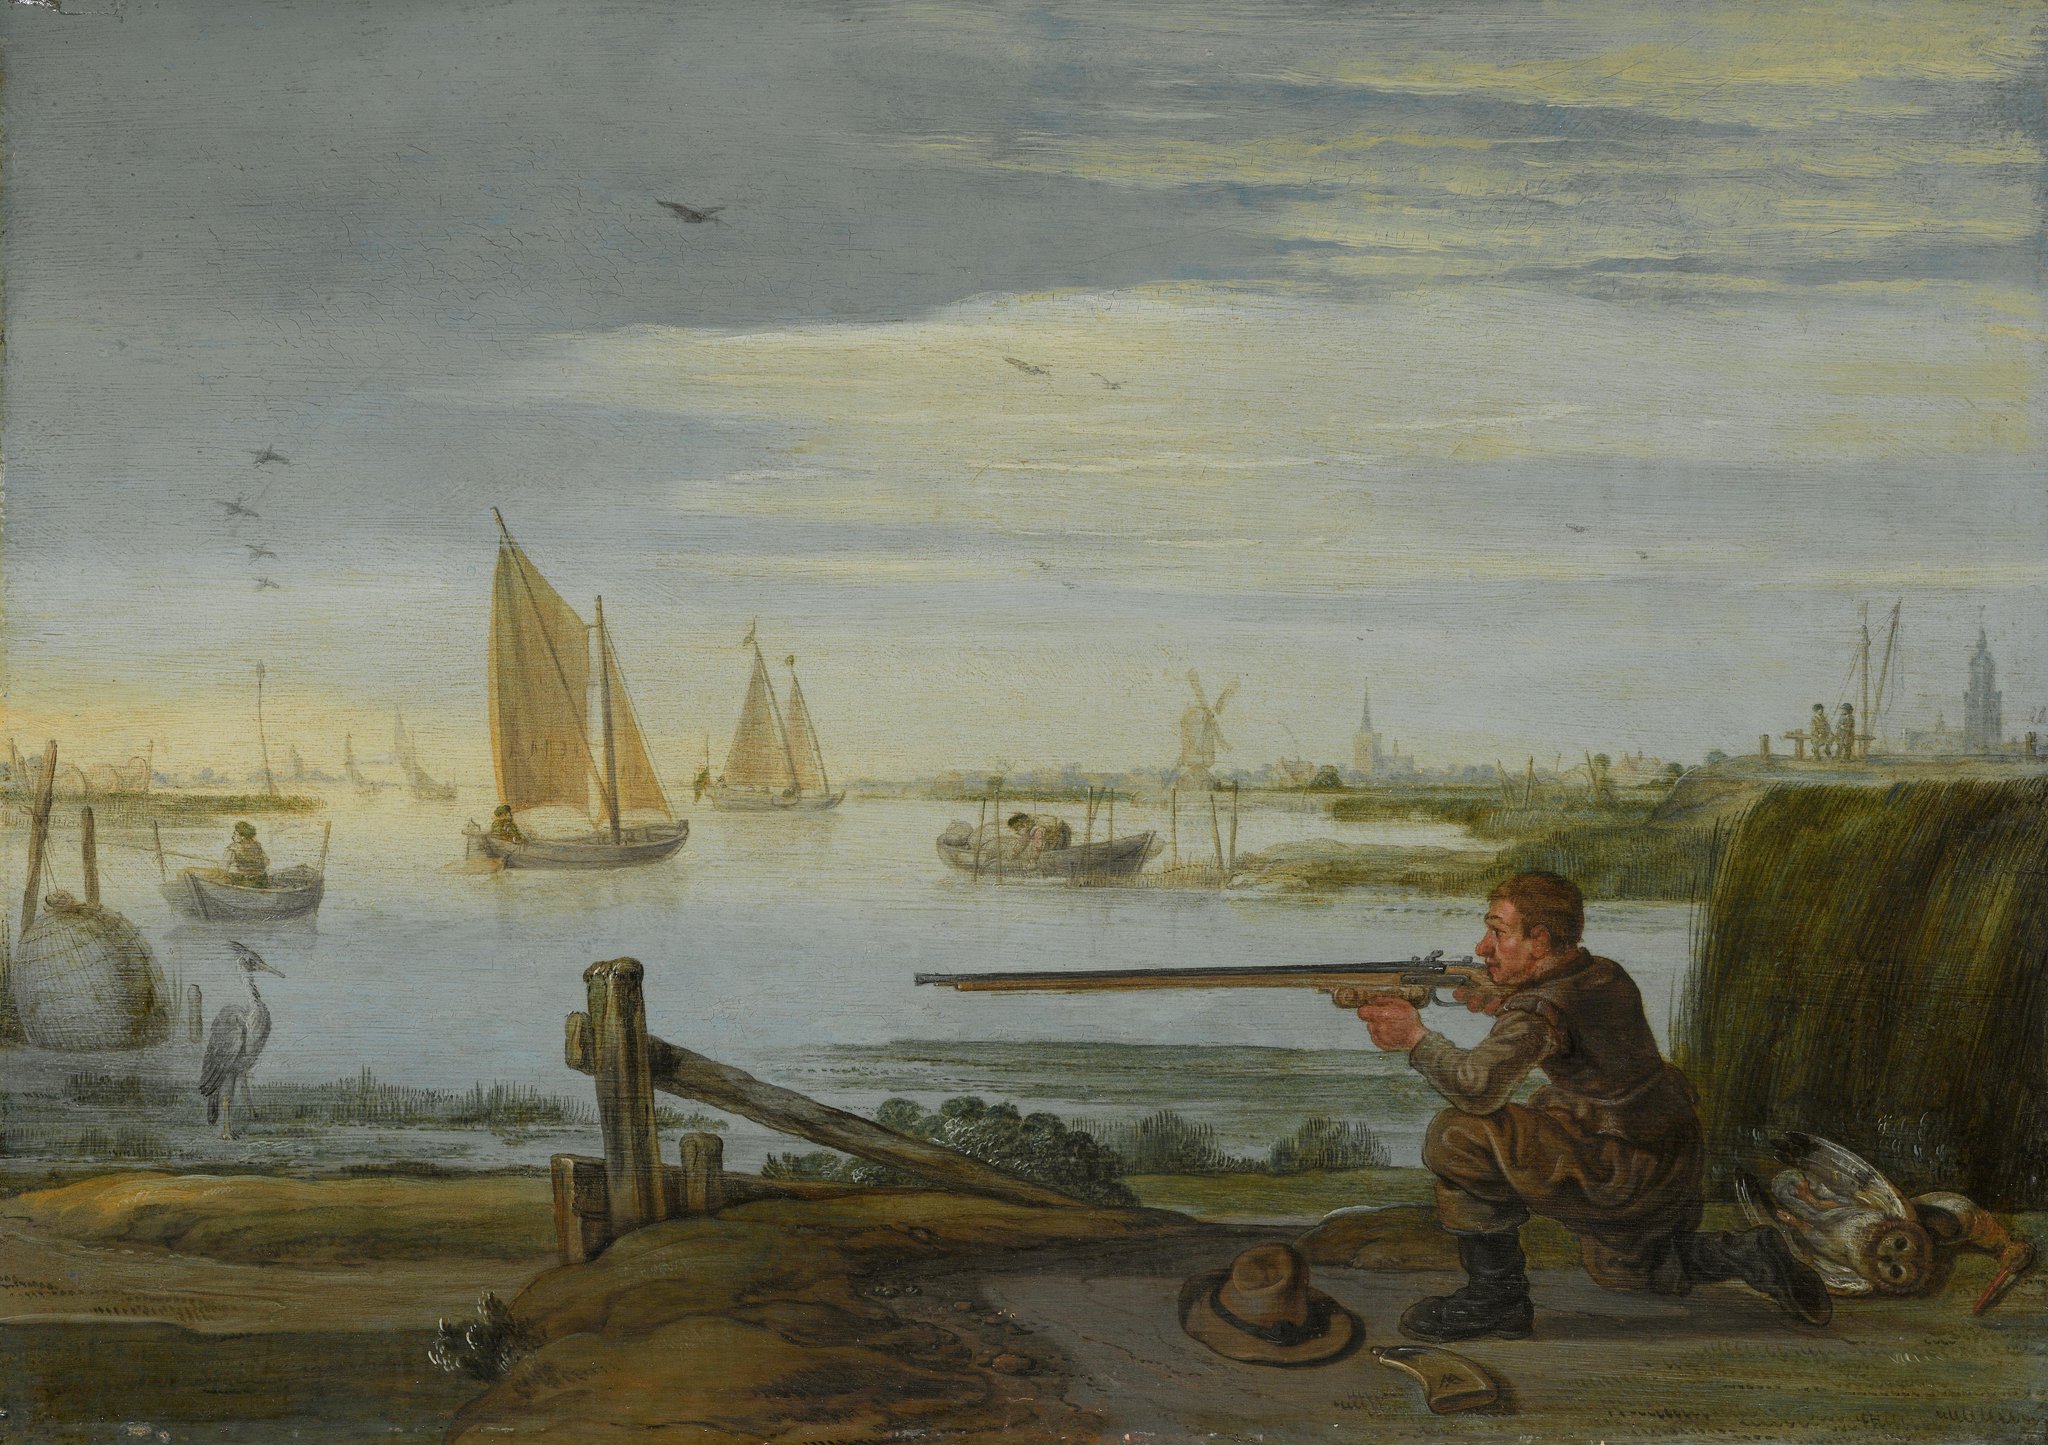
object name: painting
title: A Bird Hunter on a Riverbank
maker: arent arentsz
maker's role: draughtsman, painter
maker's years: 1585-1631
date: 1625-1630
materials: oil, panel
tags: sailing-ship, sailing-boat, river, hunters hunting (n.b.: in 1988-1990 this notation denoted the concept of 43c11421 'hunters resting during the hunt')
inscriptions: signature, in ligated monogram, at bottom centre on the powder horn: ‘AA’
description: Waterlandschap met een jager die knielt en zijn geweer op een reiger richt. Rechts een dode uil en ander gevogelte.